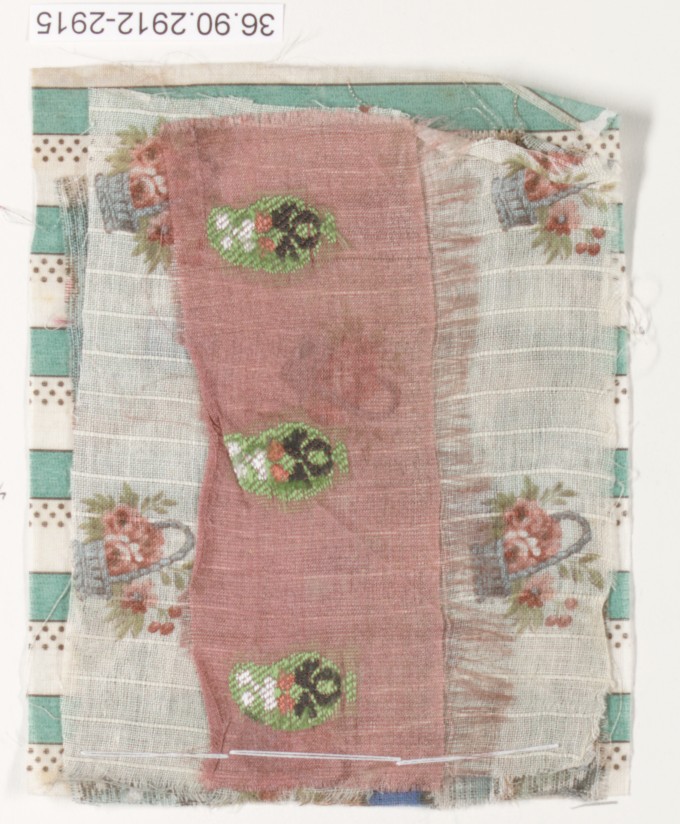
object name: piece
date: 1801-1900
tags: flowers